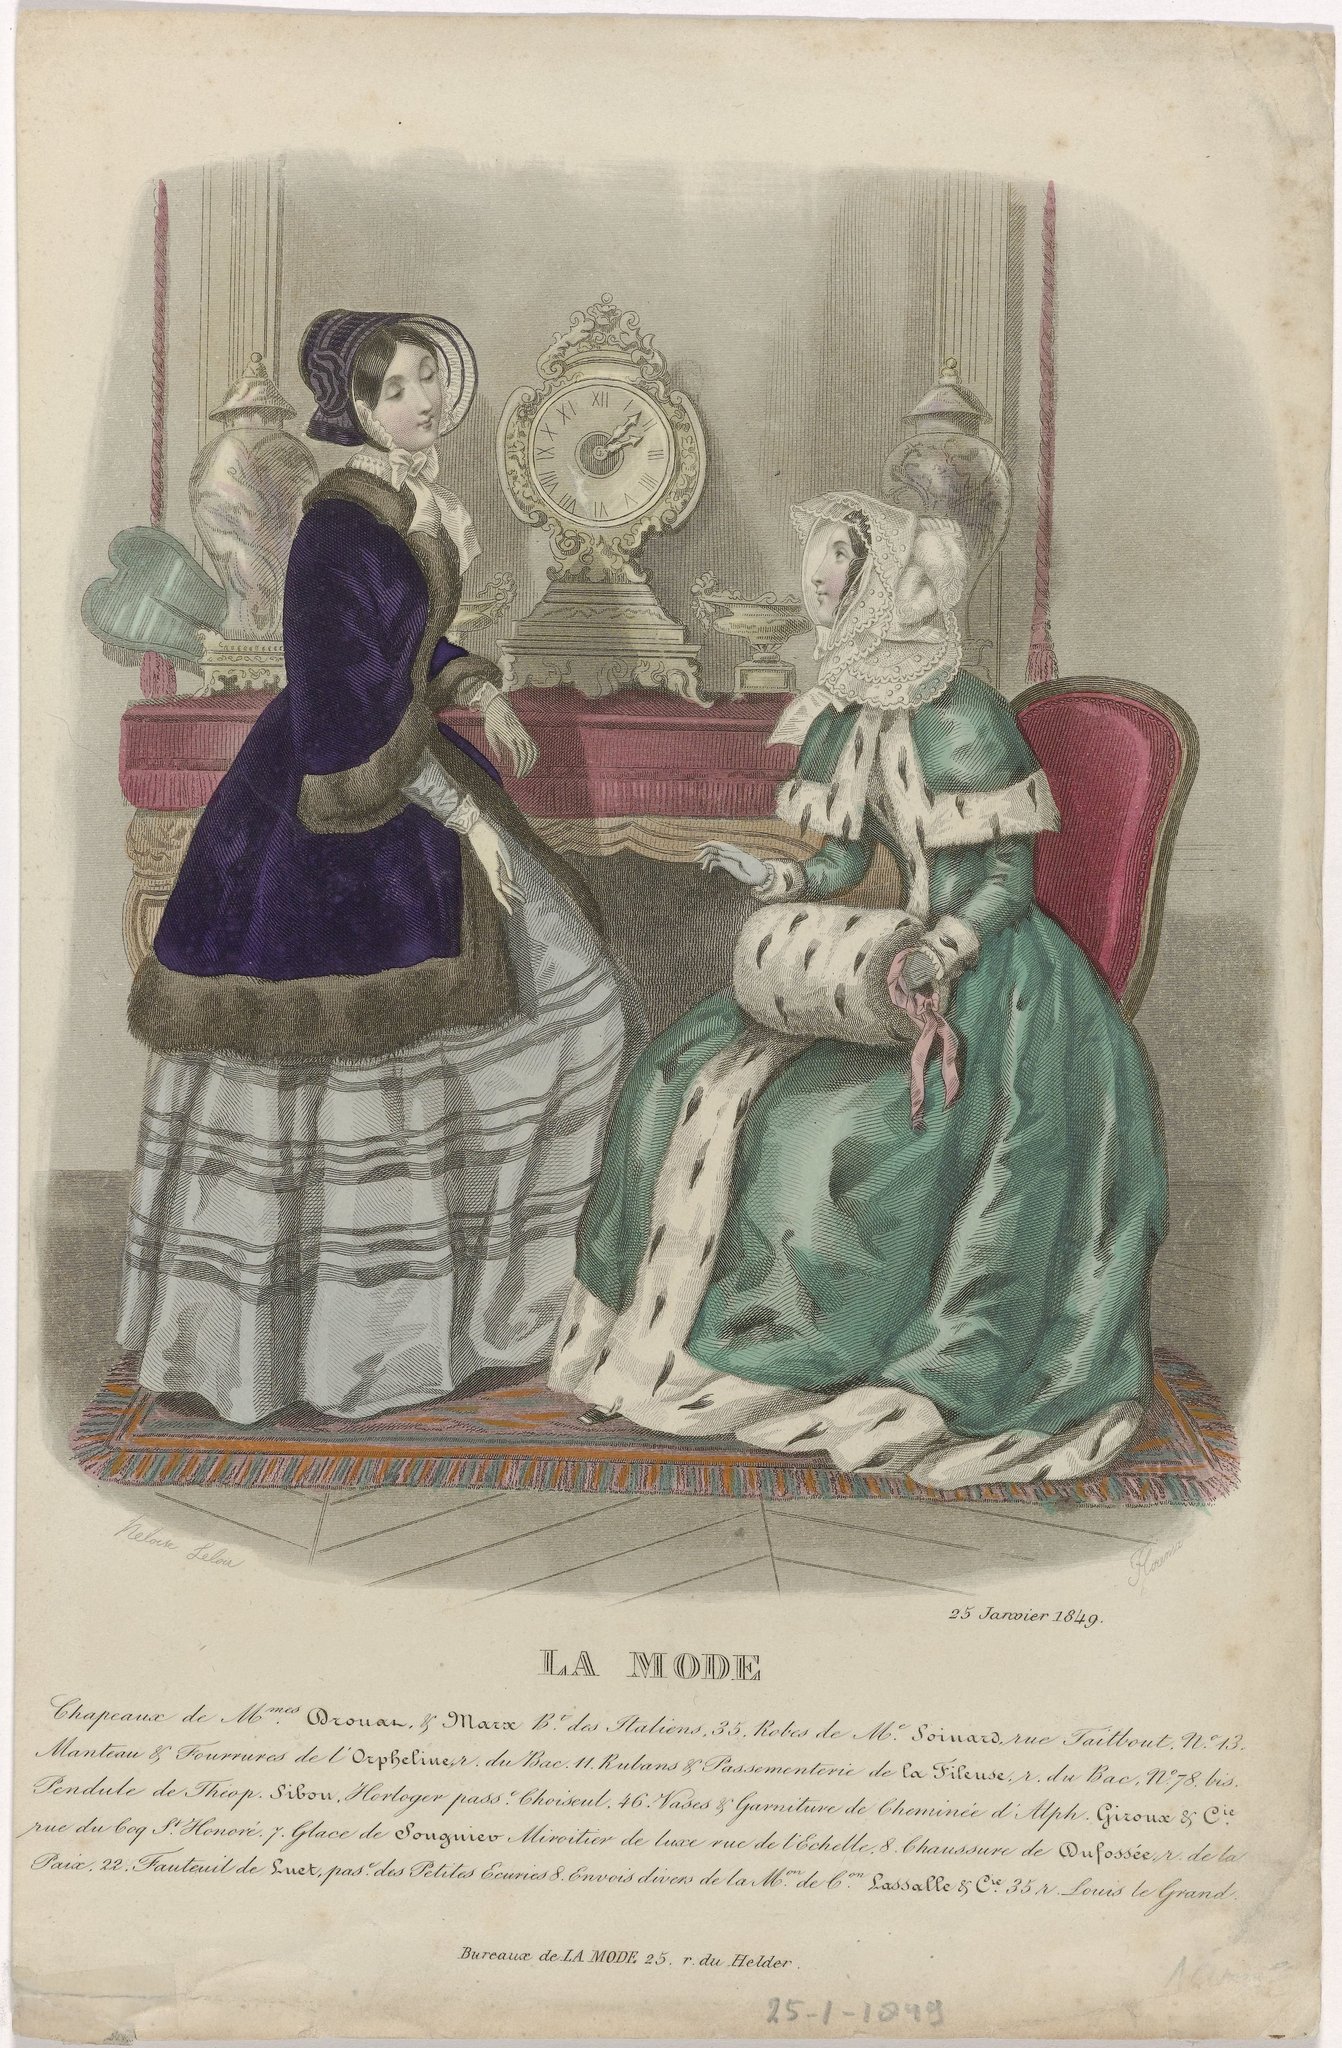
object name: fashion print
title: La Mode, 25 janvier 1849 : Chapeaux de M.mes Drouan (...)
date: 1849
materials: paper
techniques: hand coloring, engraving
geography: paris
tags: ornamental parts of clothing (+ women's clothes), border, ribbon, braid (+ women's clothes), border, ribbon, braid (+ fur used for clothes), coat (+ women's clothes), mirror, head-gear (+ women's clothes), vase ~ ornament, fashion plates, shoes, sandals (+ women's clothes), dress, gown (+ women's clothes), clock, container of ceramics: jar, jug, pot, vase, muff (+ fur used for clothes)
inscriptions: title: ‘La Mode’, address: ‘Bureaux de La Mode, 25, R. du Helder’, caption: ‘Chapeau de M.mes Drouan & Marx B.t des Italiens, 35. Robes de M.e Soinard, rue Taitbout, N.o 13. Manteau & Fourrures de l'Orpheline, r. du Bac.11. Rubans & Passementerie de la Fileuse, r. du Bac, N.o 78.bis. Pendule de Théop. Sibou, Horloge pass.e Choiseul.46. Vases & Garniture de Cheminée d'Alph. Giroux & C.ie rue du Coq S.t Honoré. 7. Glace de Sougnier Miriotier de luxe rue de l'Echelle. 8. Chaussure de Dufossée. r. de la Paix. 22. Fauteuil de Luet, pas.e des Petites Ecuries 8. Envois divers de la M.on de C.on Lassalle & C.ie 35 r. Louis le Grand.’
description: Twee vrouwen bij een schoorsteenmantel waarop twee vazen en een pendule. Volgens het onderschrift: hoeden van Drouan en Marx. Japonnen van Soinard. Mantel en bont van Orpheline. Linten en passementen van la Fileuse. 'Pendule de Théop.' van Sibou. Vazen en garnering van 'Cheminée d'Alph' van Giroux & Cie. Hieronder enkele regels reclametekst voor verschillende producten. Prent uit het modetijdschrift La Mode (1829-1855).